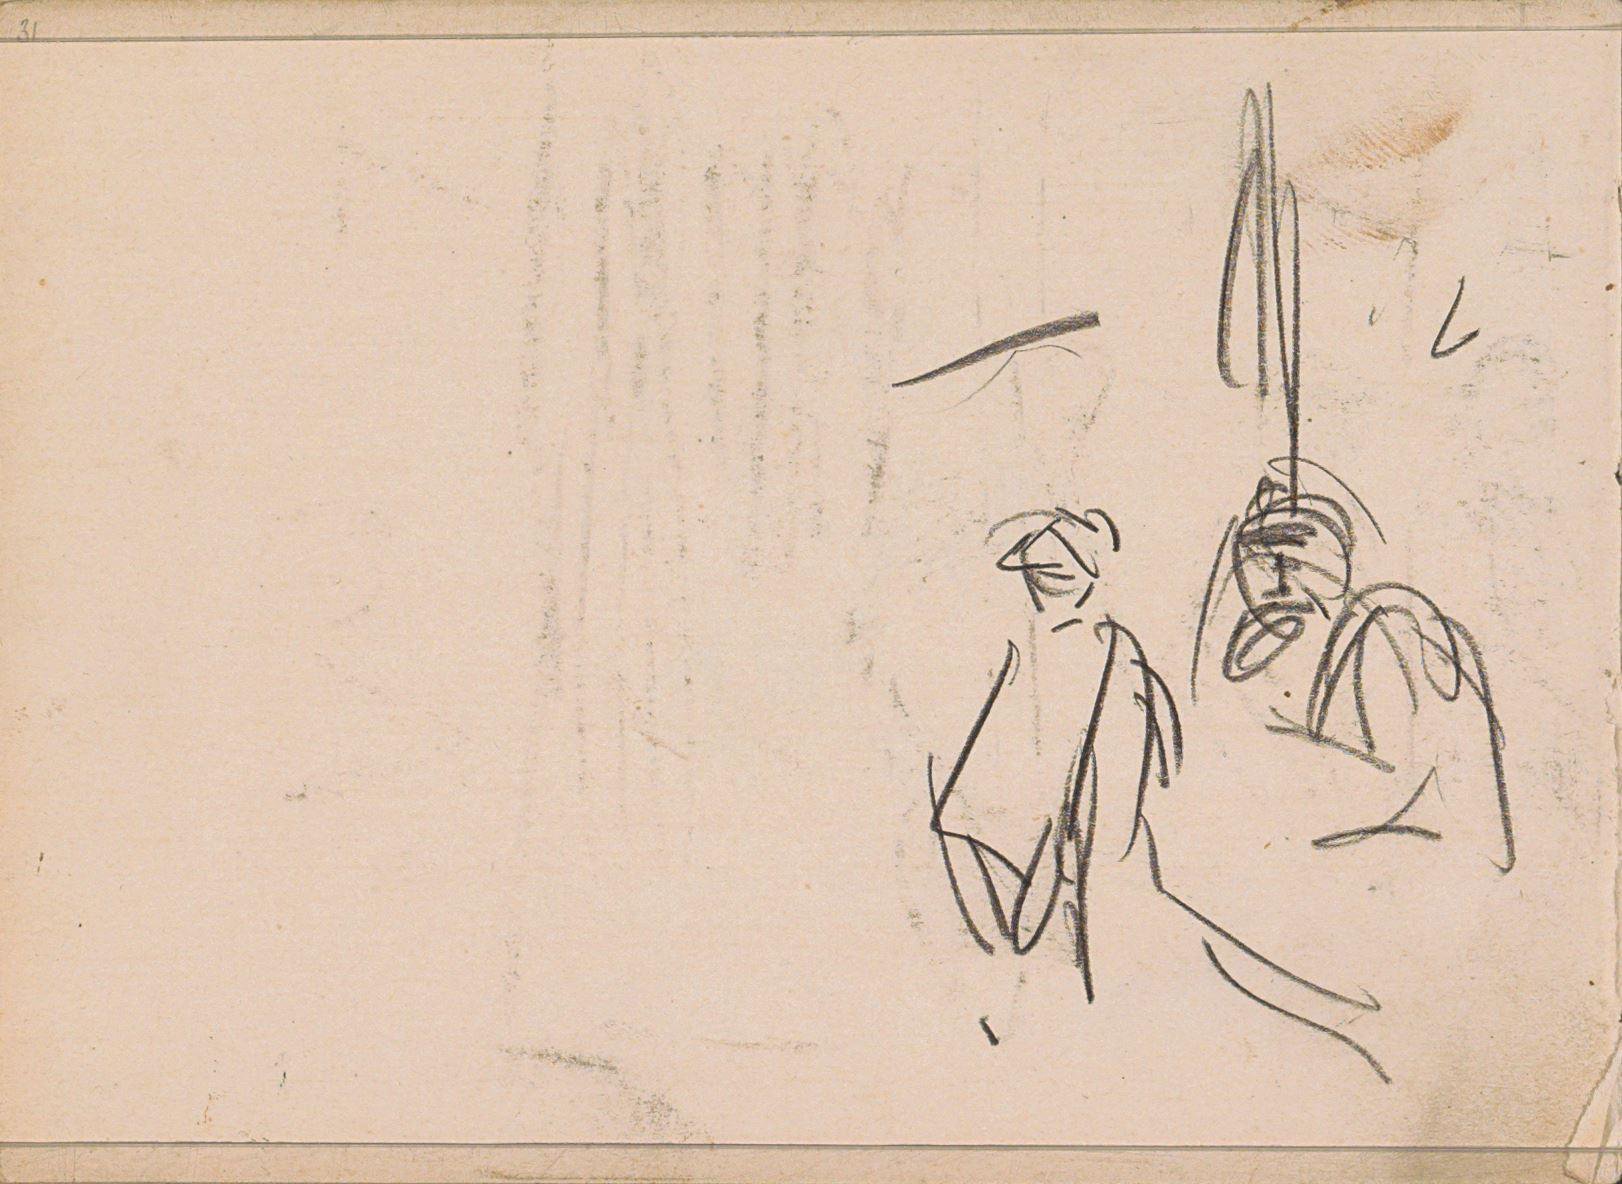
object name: sketchbook leaf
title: Twee figuren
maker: isaac israels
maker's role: draughtsman, painter, print maker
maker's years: 1865-1934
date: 1875-1934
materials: chalk, paper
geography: paris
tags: the (nude) human figure; 'corpo humano' (ripa)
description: Pagina 31 uit schetsboek XLV met 85 pagina's.